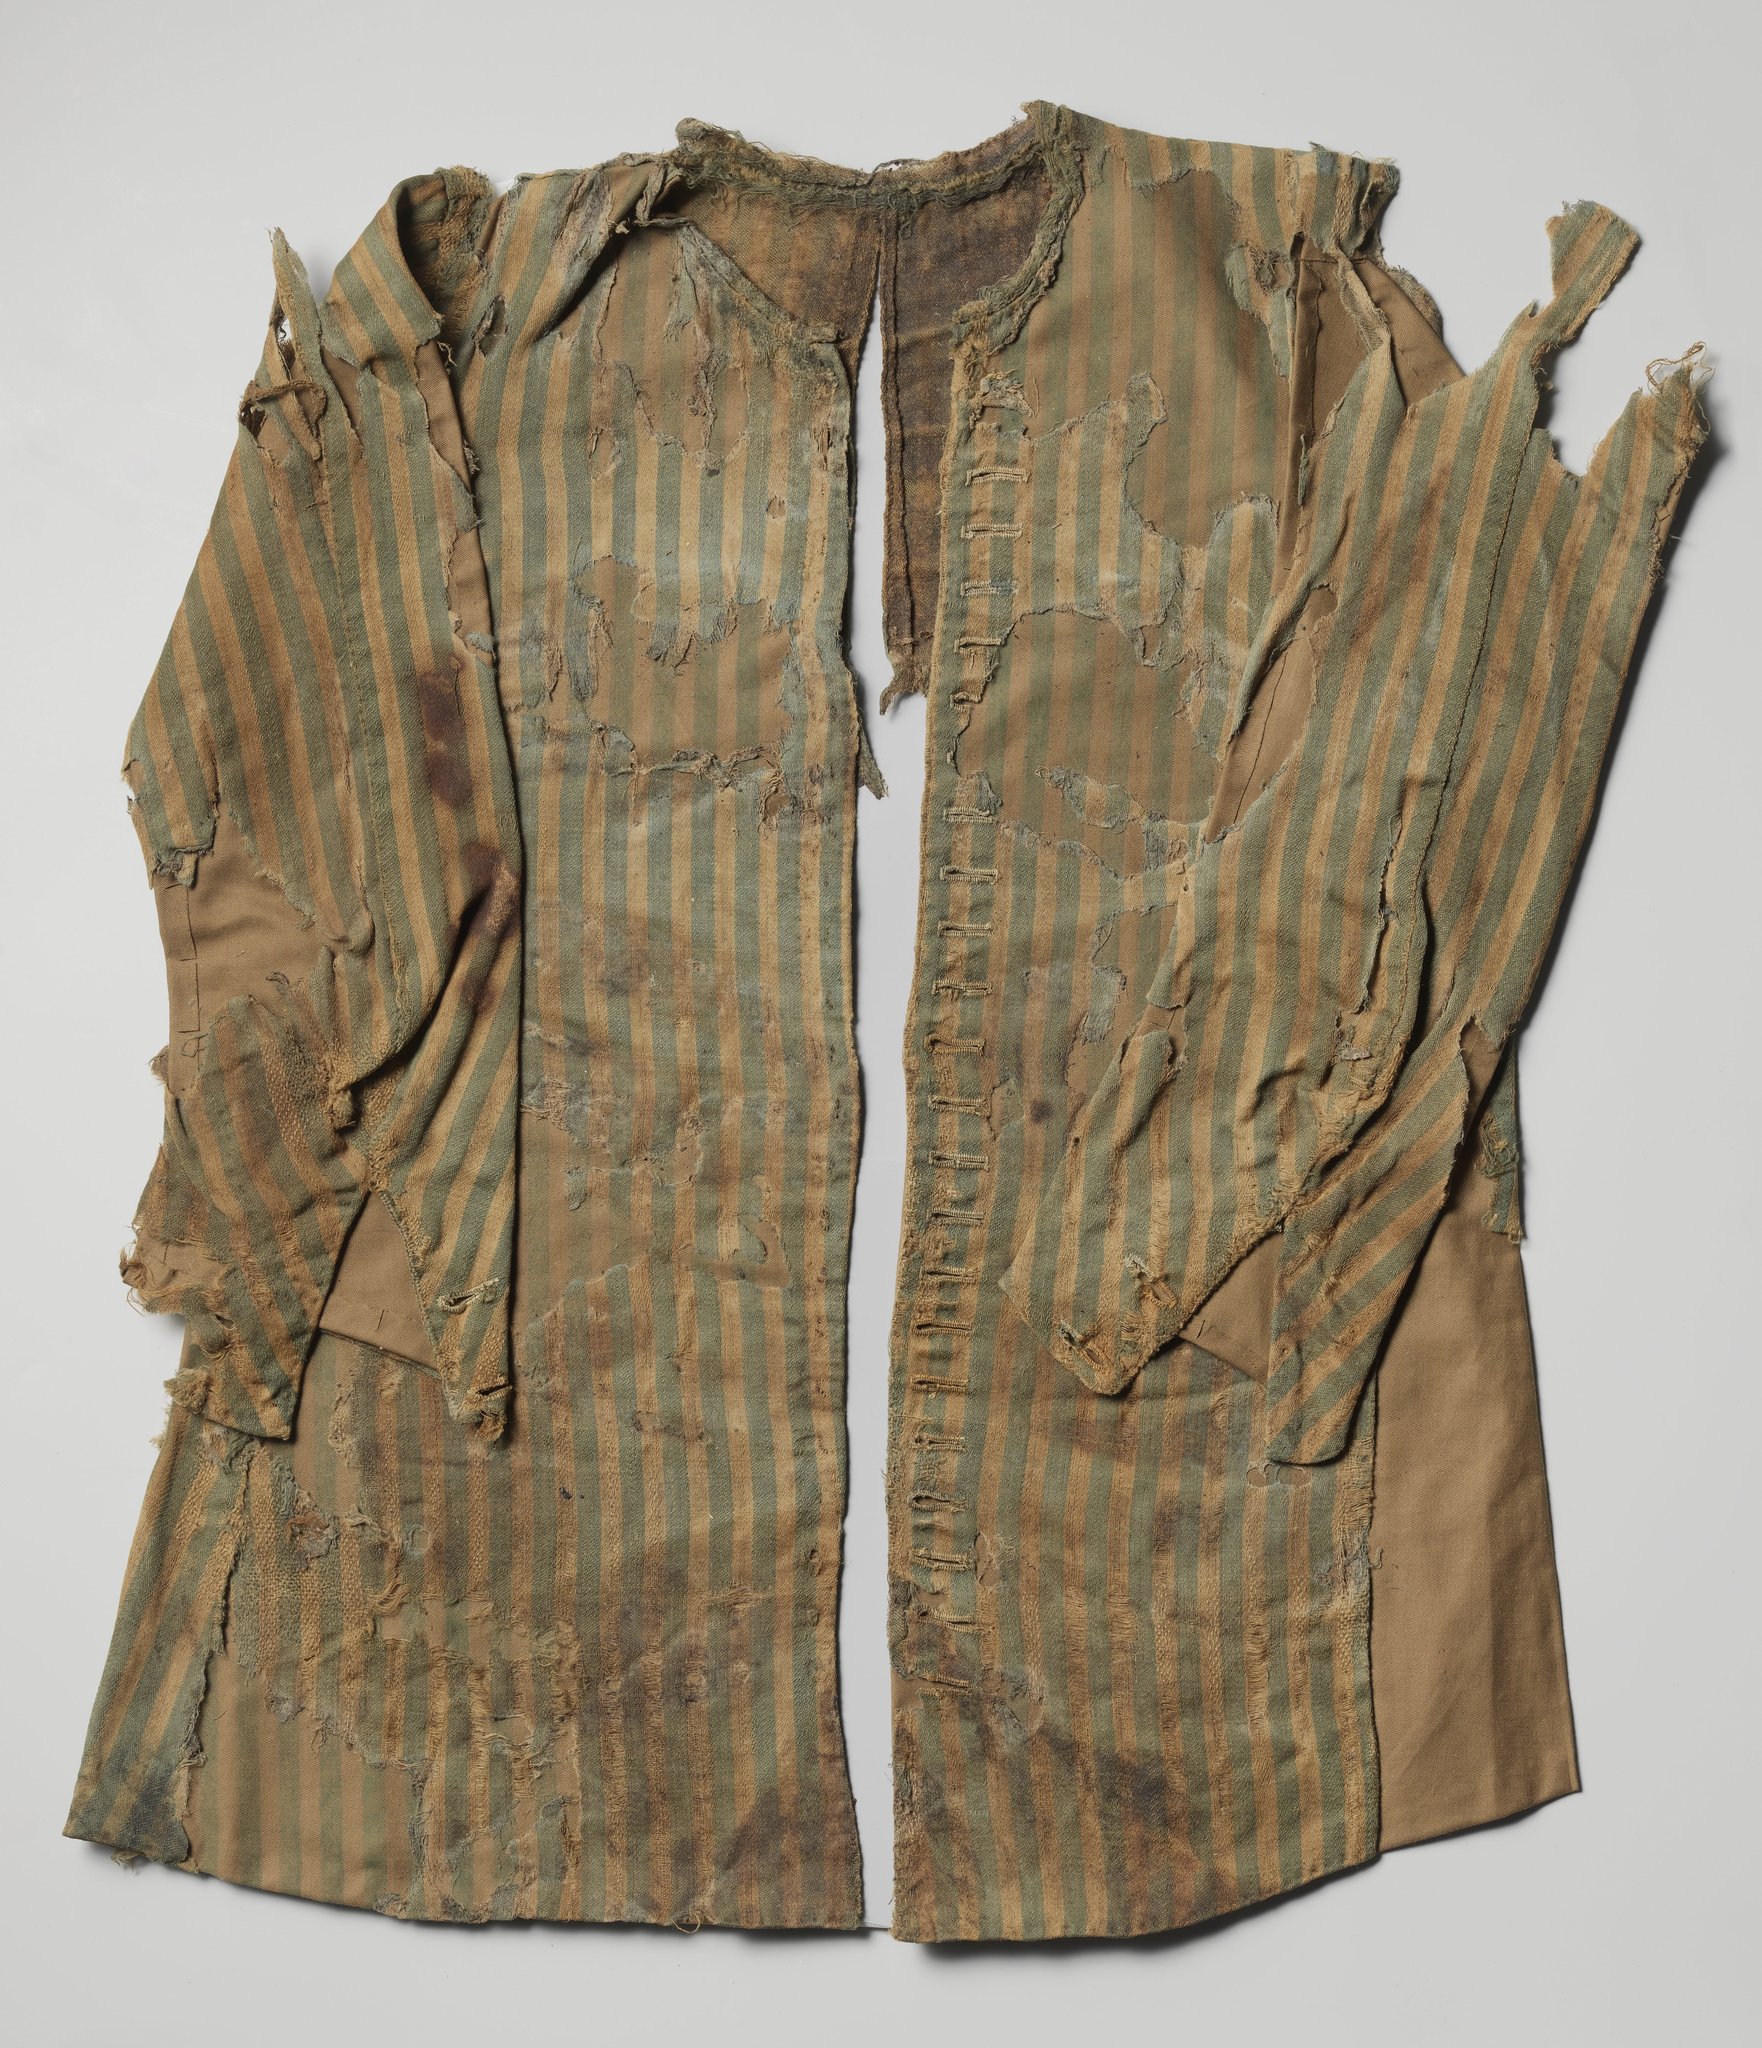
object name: fragment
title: Jas, groen met wit gestreept, van dunne, soepele stof, met losse mouw en knopen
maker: Anonymous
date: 1740-1760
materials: wool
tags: noordse compagnie, spitsbergen, zeeuwsche uytkyck, svalbard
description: Jas, groen met wit gestreept, van dunne, soepele stof. Bij de jas worden een losse mouw, enige fragmenten textiel en 9 losse knopen bewaard.